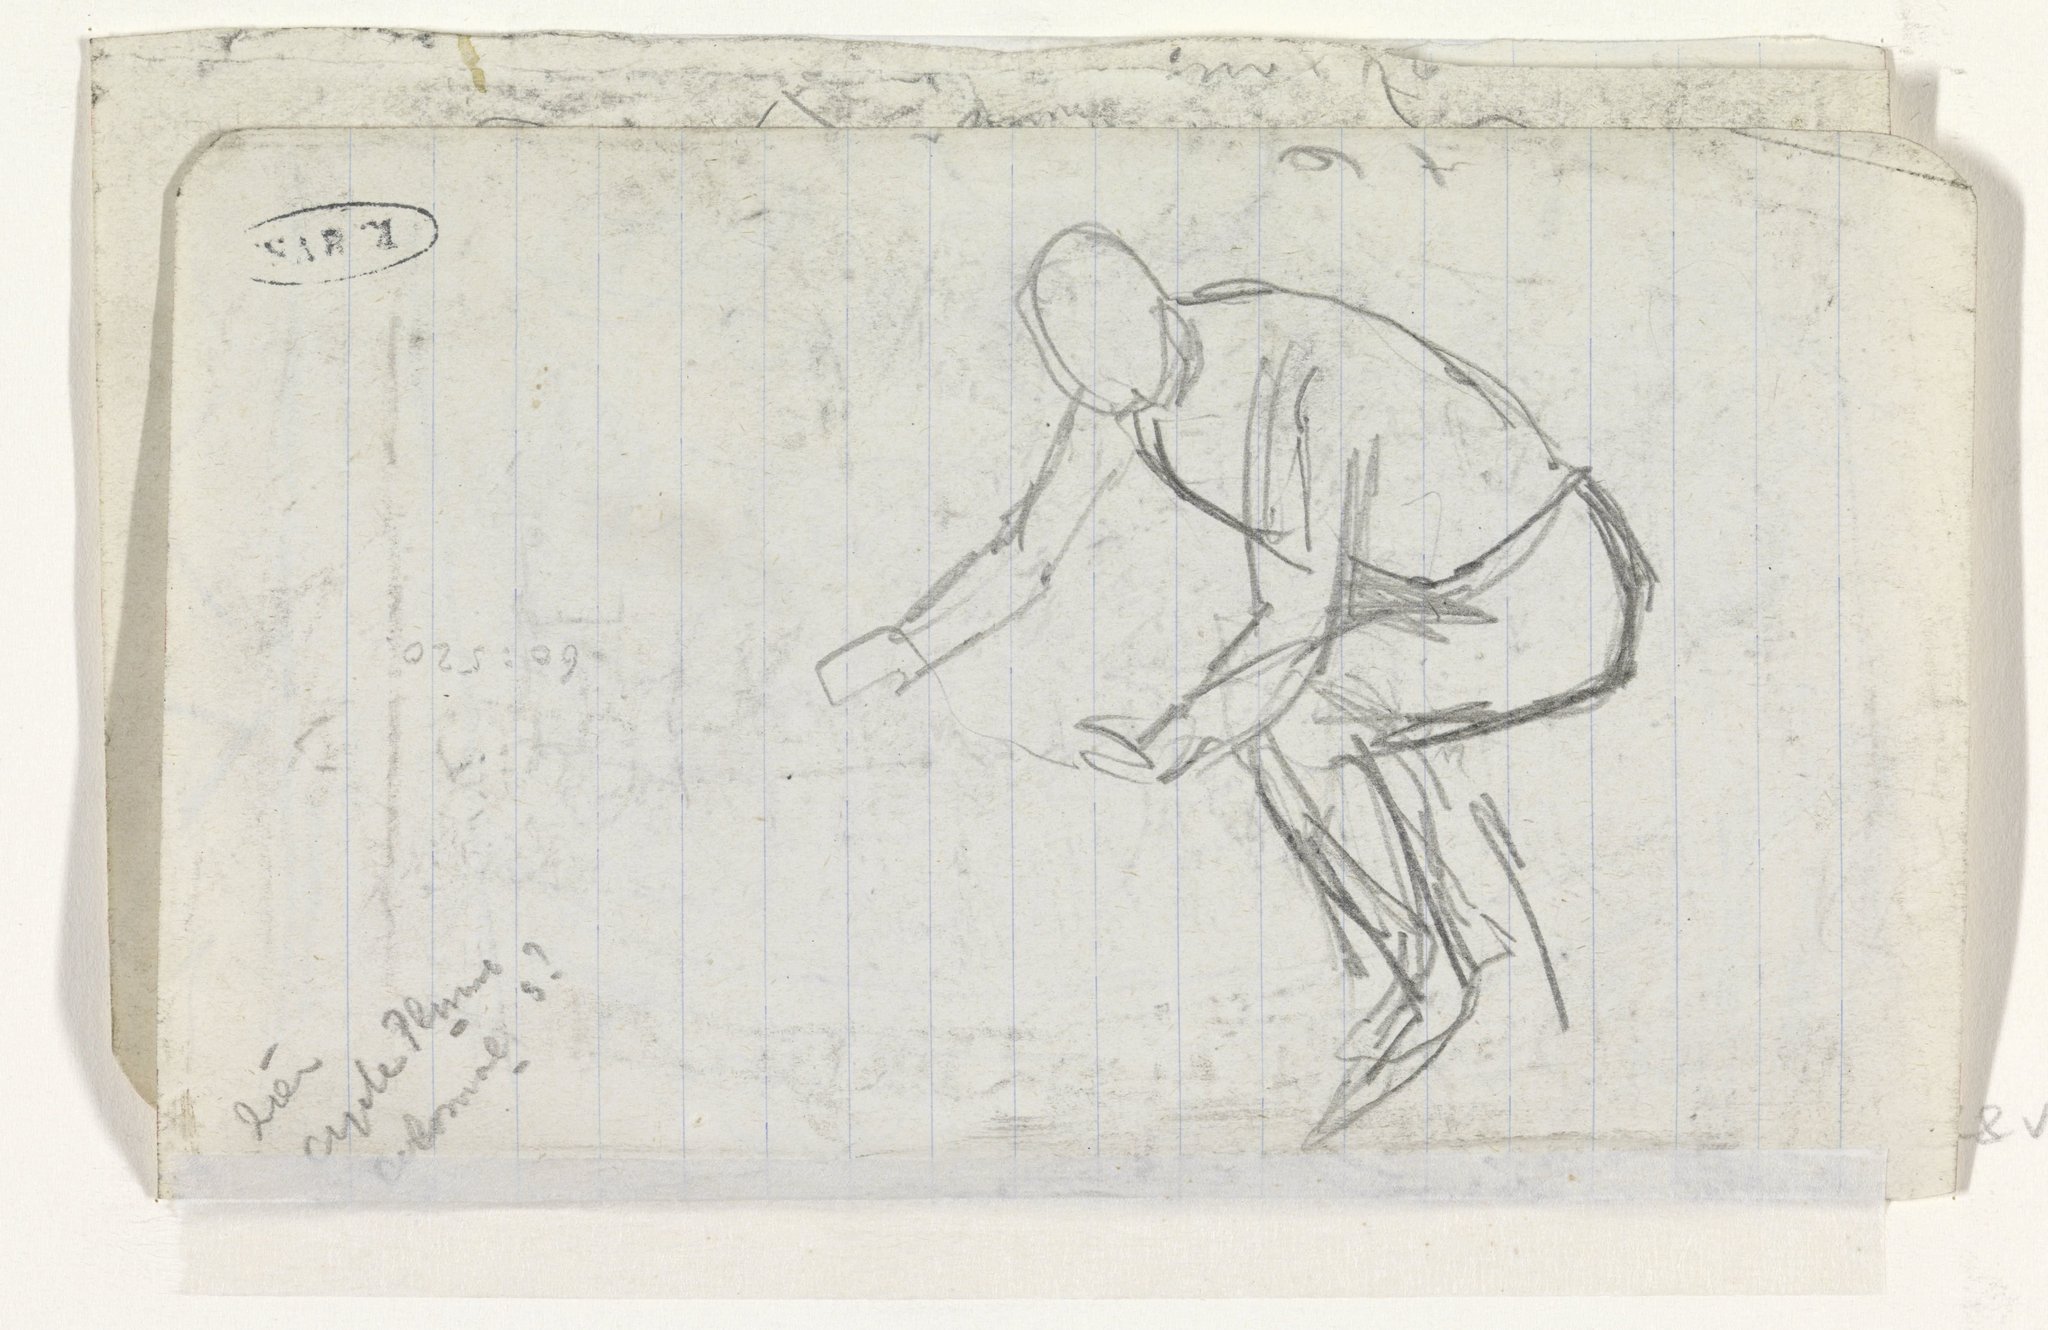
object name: drawing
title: Wielrenner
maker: leo gestel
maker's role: draughtsman, print maker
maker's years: 1881-1941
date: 1891-1941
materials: pencil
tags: bicycle racing (+ sportsman, player, etc.)